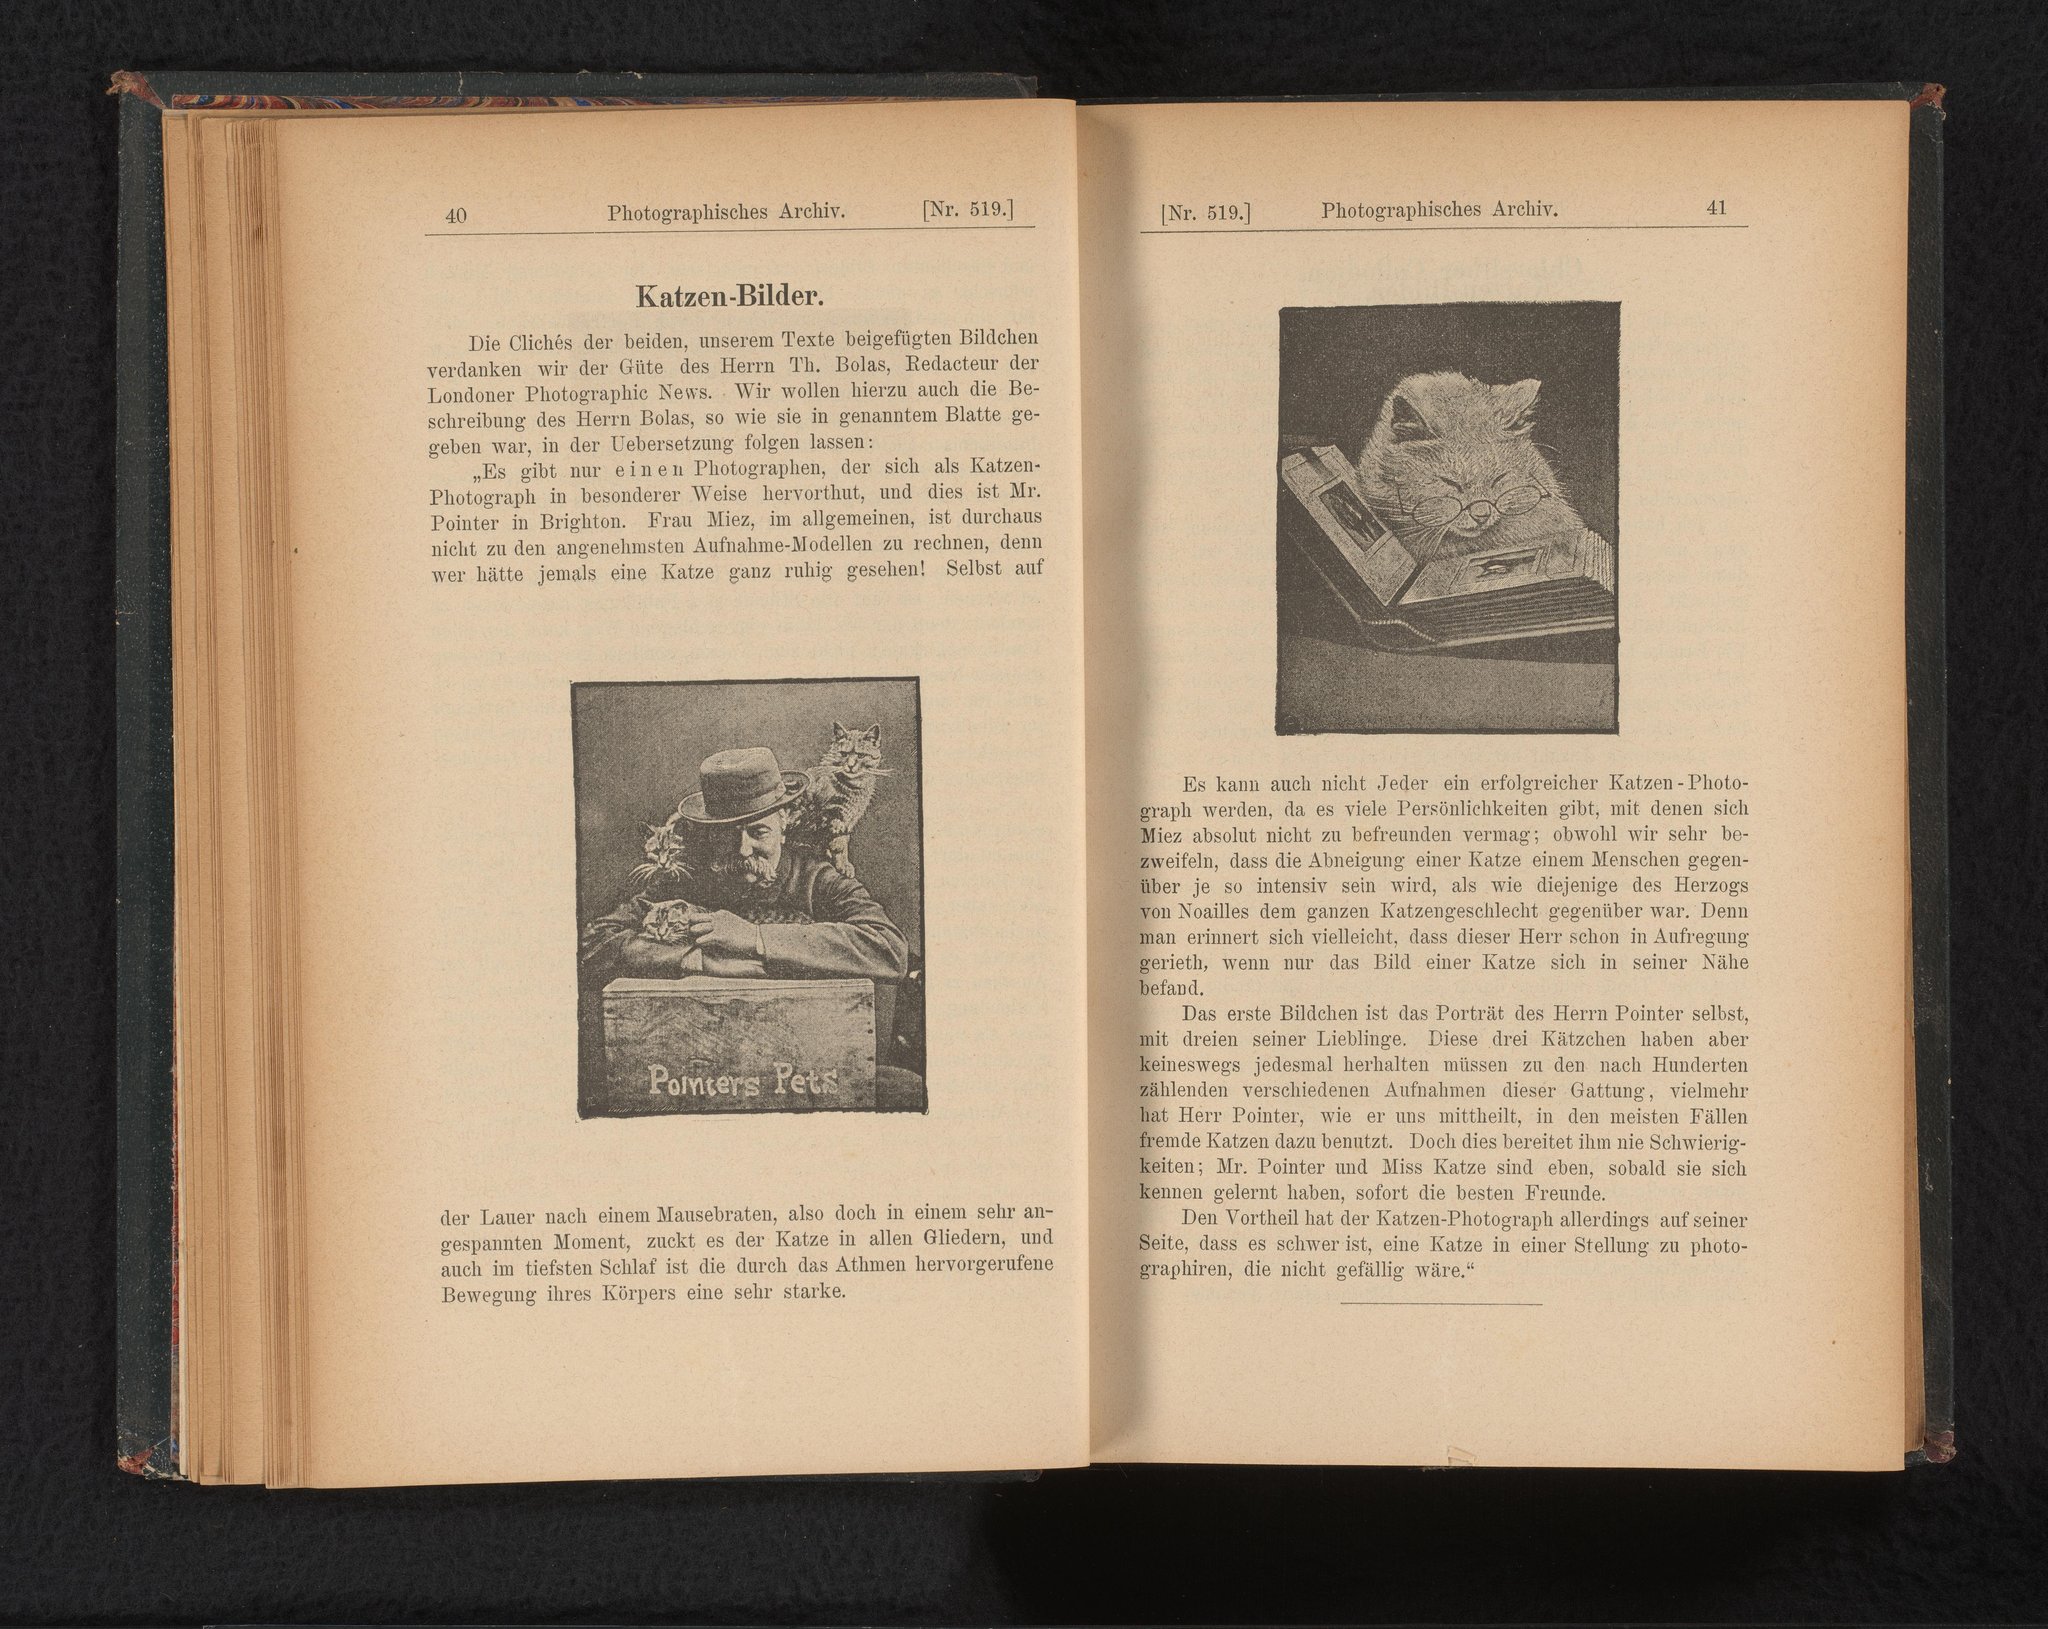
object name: page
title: Kat met bril kijkt in album met kattenfoto's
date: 1880-1885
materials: paper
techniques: autotype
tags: eyeglasses, spectacles, 'album amicorum', 'stammbuch', cat